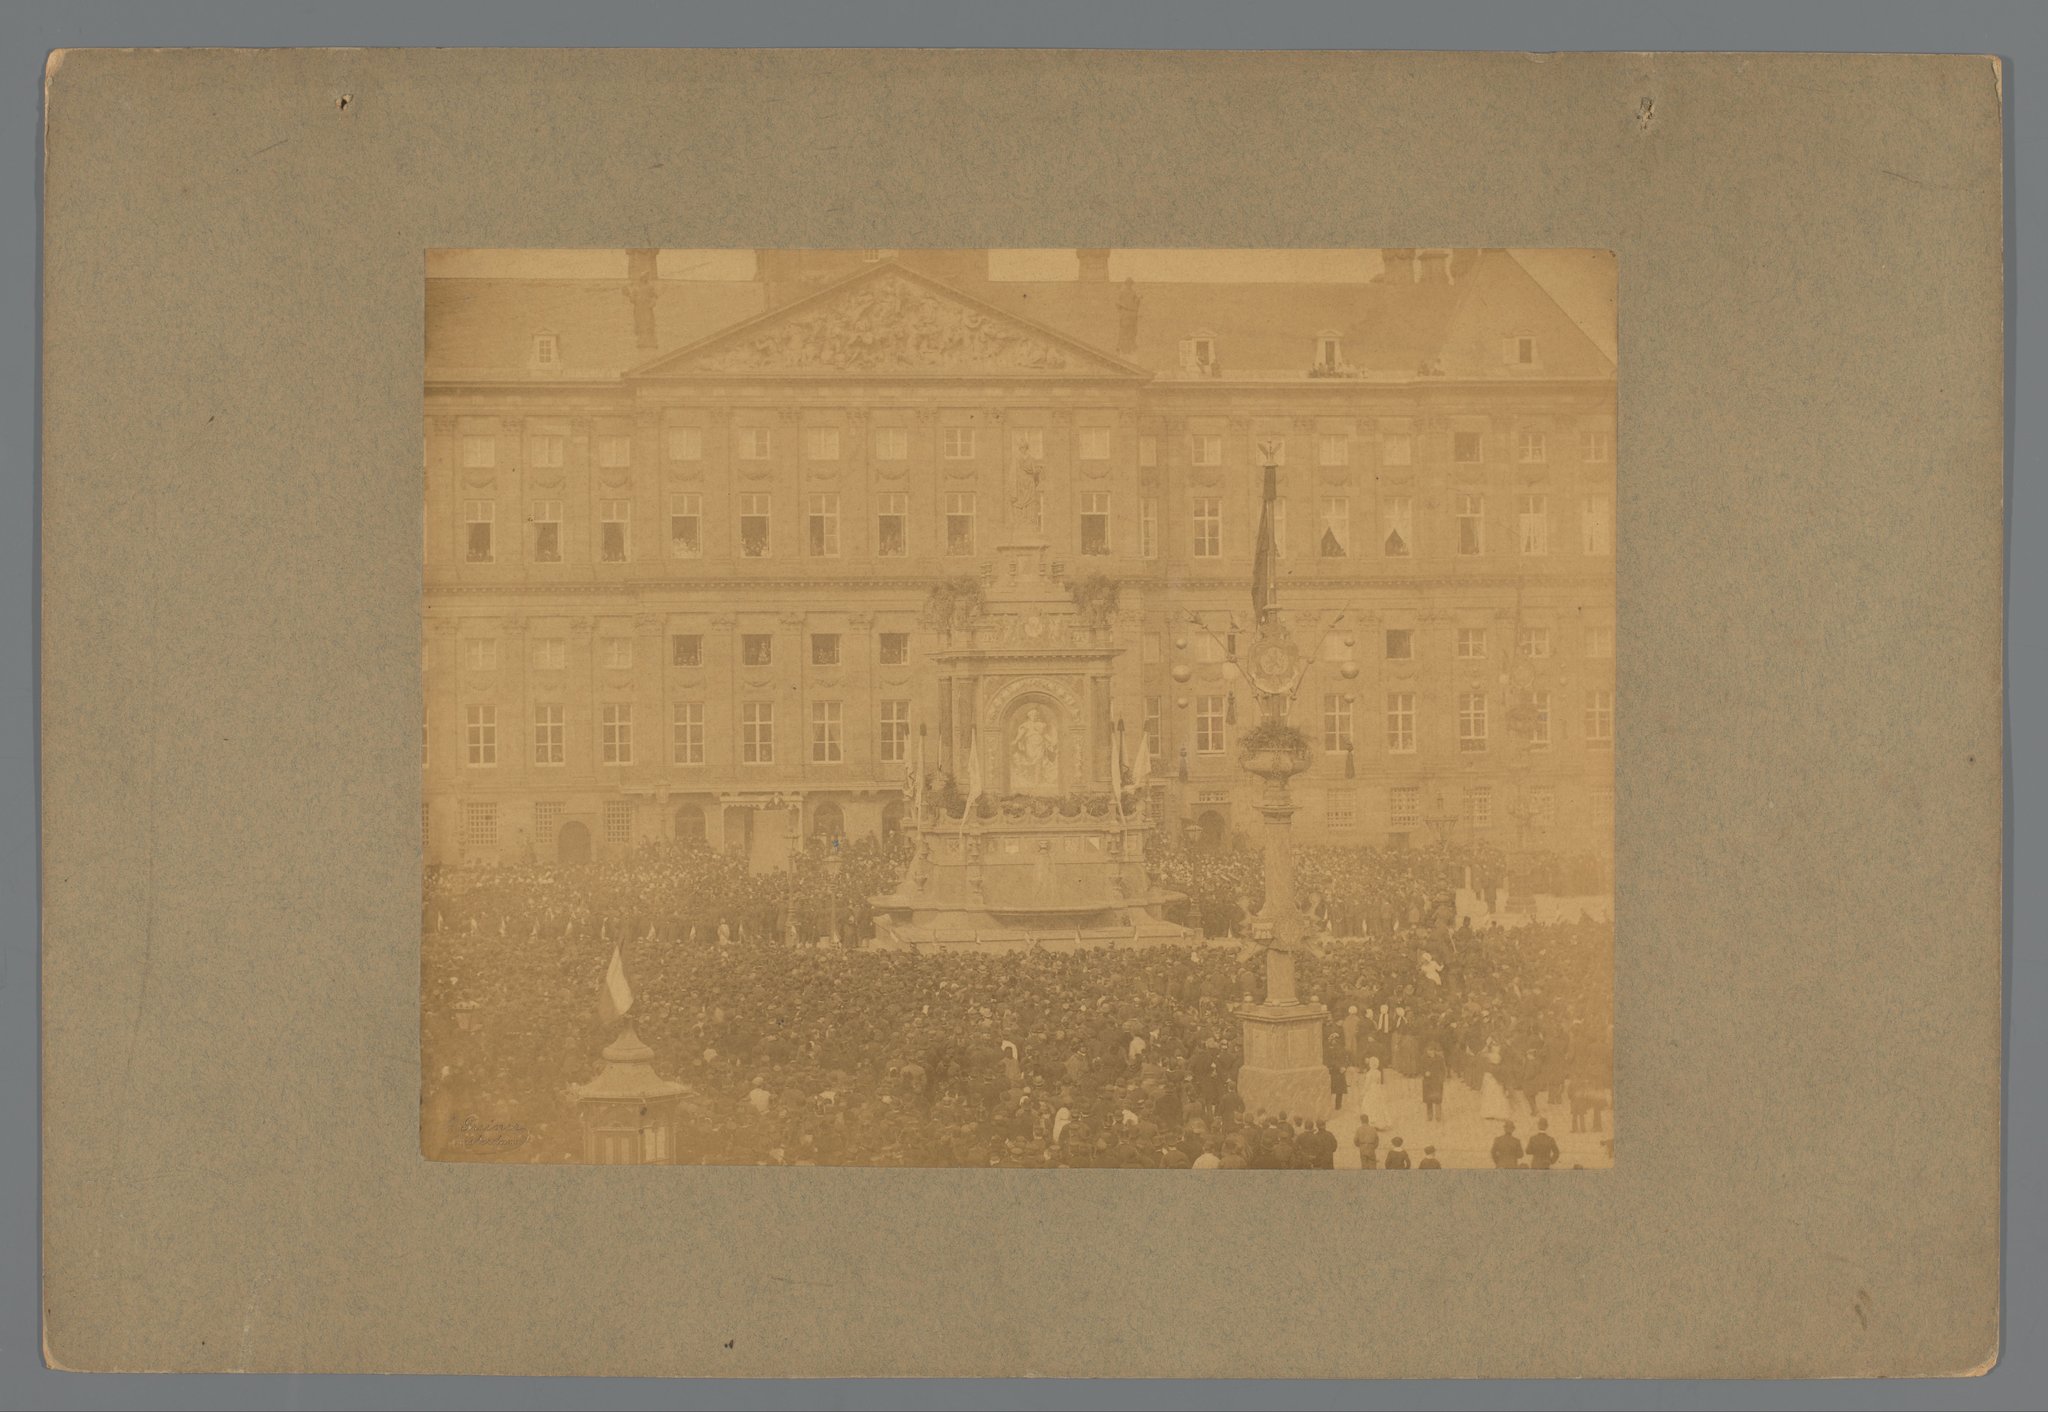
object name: photograph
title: Aprilfeesten 1887: aankomst van de stoet op de Dam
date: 1887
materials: cardboard, paper, photographic support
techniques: albumen print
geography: amsterdam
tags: brussels, willem iii (koning der nederlanden), public festivities on the occasion of royal events, palace, piece of sculpture, reproduction of a piece of sculpture, royal palace of amsterdam, amsterdam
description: Aankomst van de stoet op de Dam. Onderdeel van een ensemble bestaande uit zes losse foto's, een titelblad en vijf tekstbladen. Naar aanleiding van de Aprilfeesten gevierd te Amsterdam op 13 april 1887, ter gelegenheid van de 70e verjaardag van koning Willem III. Uitgegeven ten voordele van het Genootschap Liefdadigheid naar Vermogen.